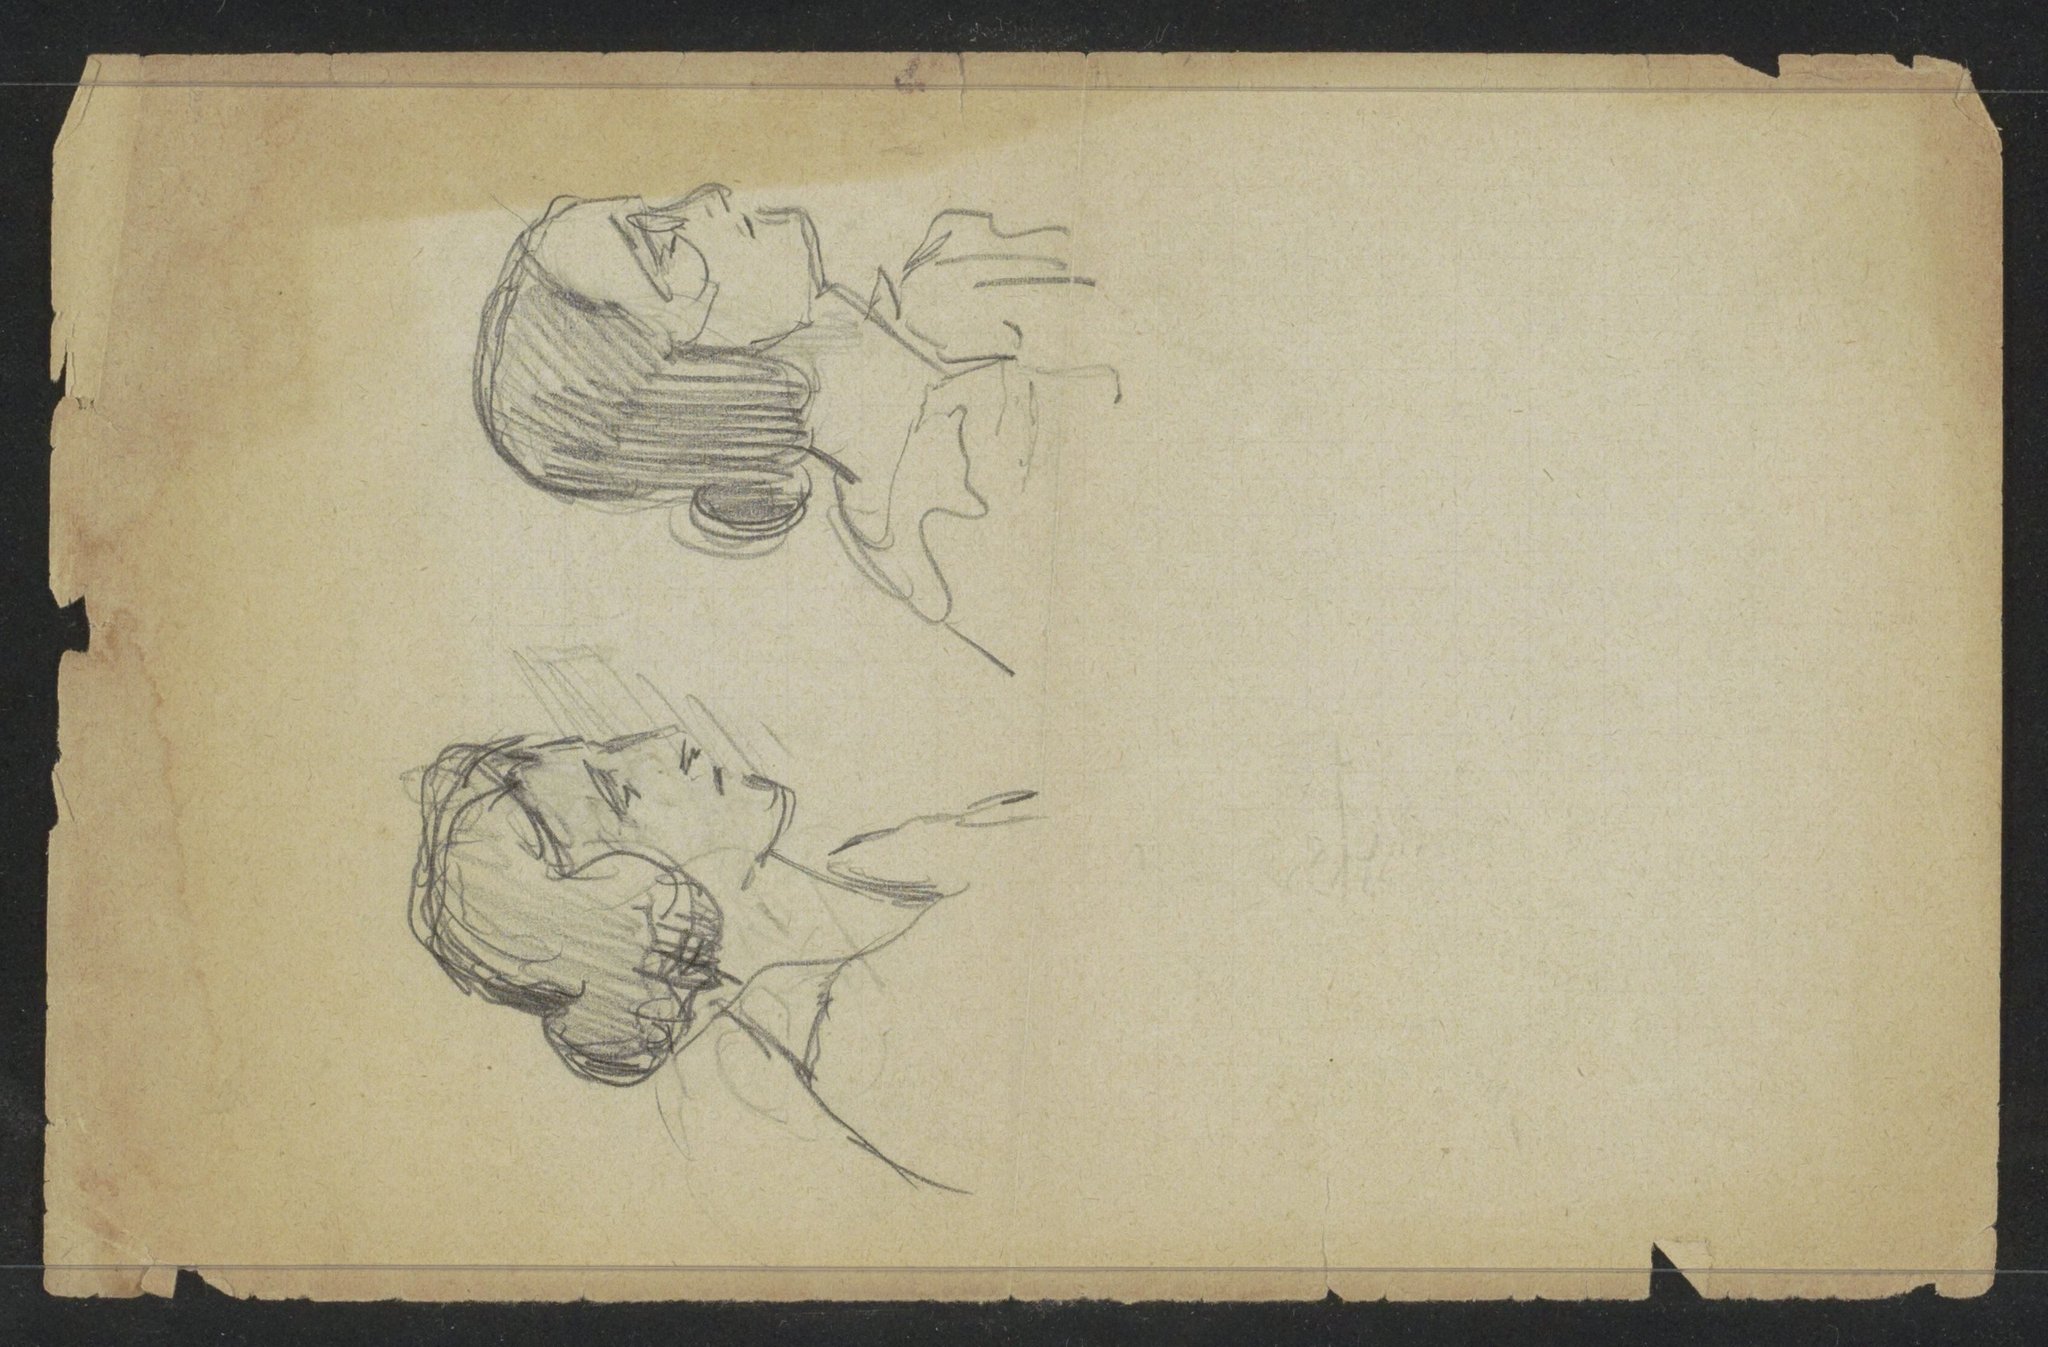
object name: sketchbook leaf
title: Twee vrouwen met opgestoken haar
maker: johanna van de kamer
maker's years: 1873-1922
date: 1883-1922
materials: pencil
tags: head (human) - aa - female human figure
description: Recto van een losse tekening tussen blad 27 en het achterste schutblad van een schetsboek met 27 bladen.